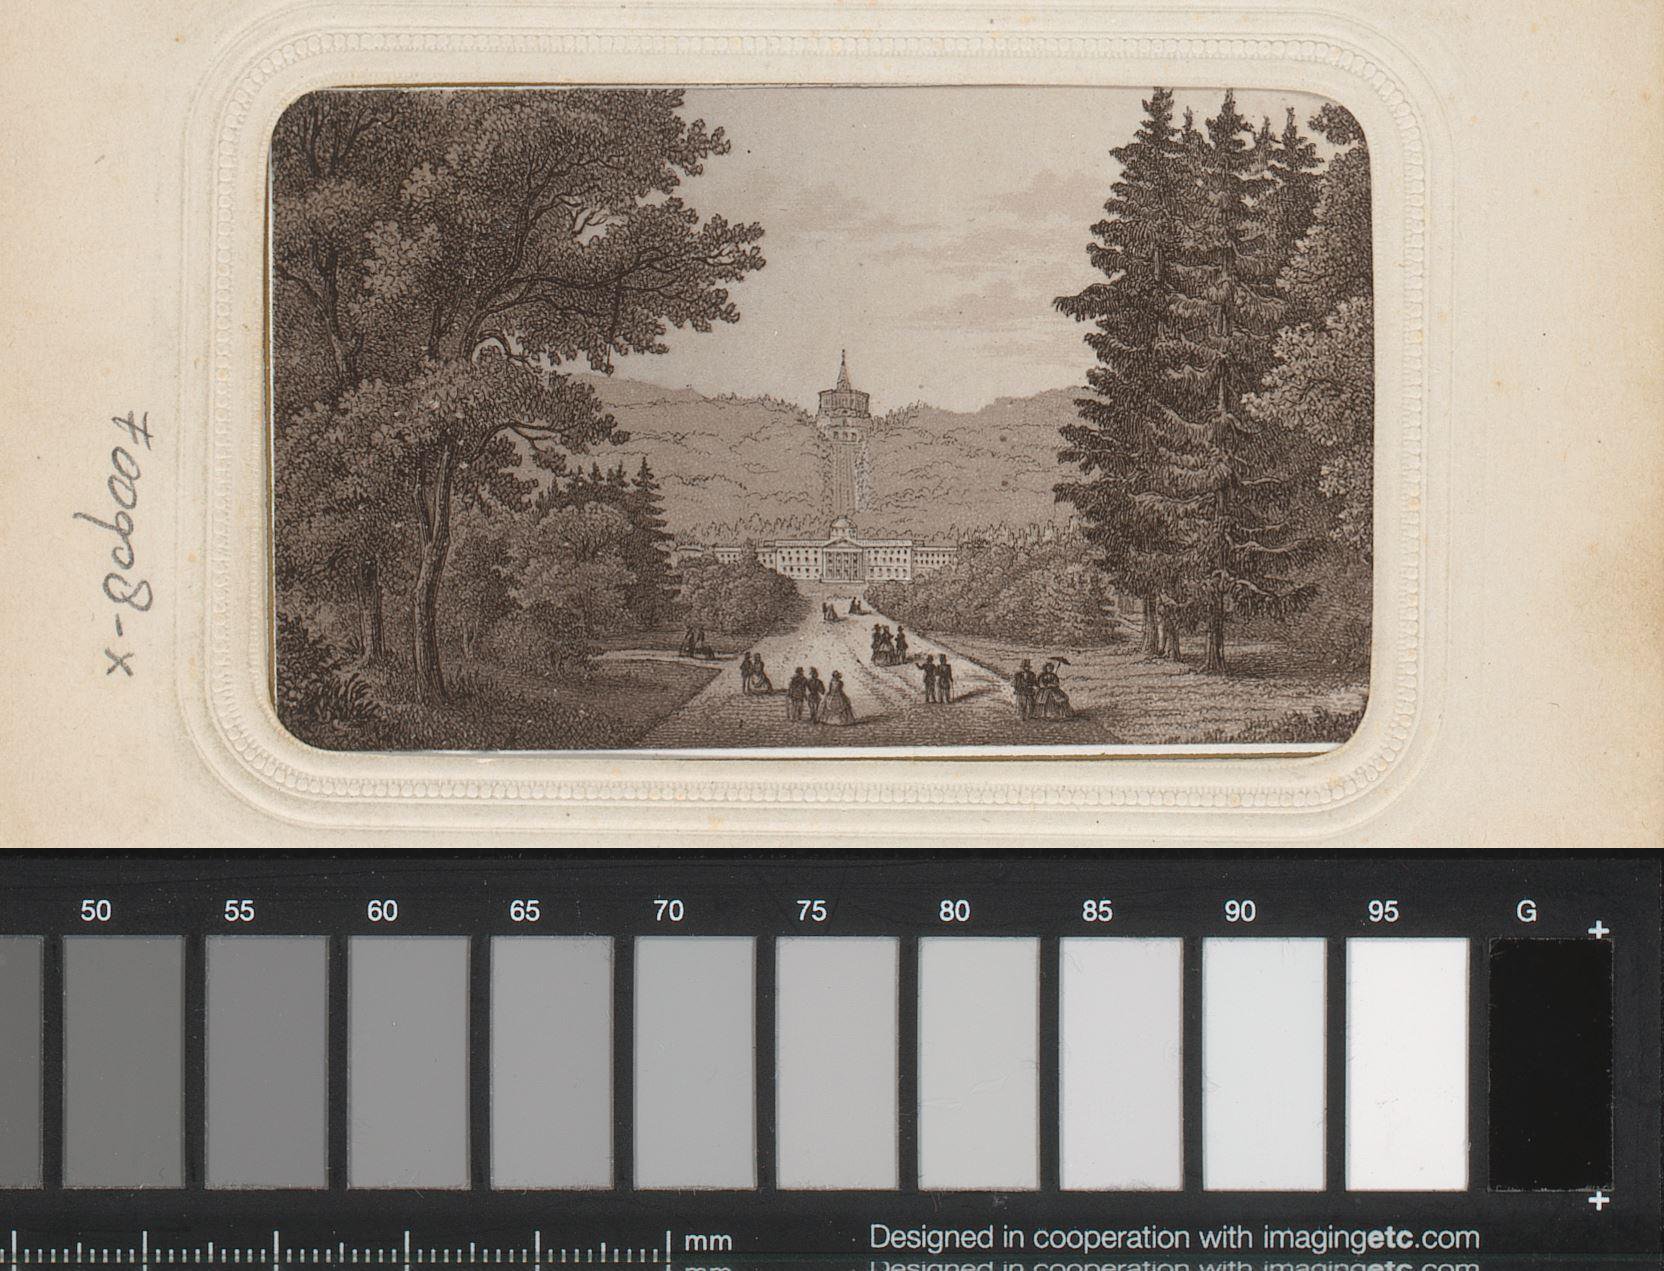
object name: reproduction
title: Wilhelmshöhe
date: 1860-1885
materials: cardboard, photographic support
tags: trees, castle, road, path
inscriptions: annotation: ‘Willemshöhe’